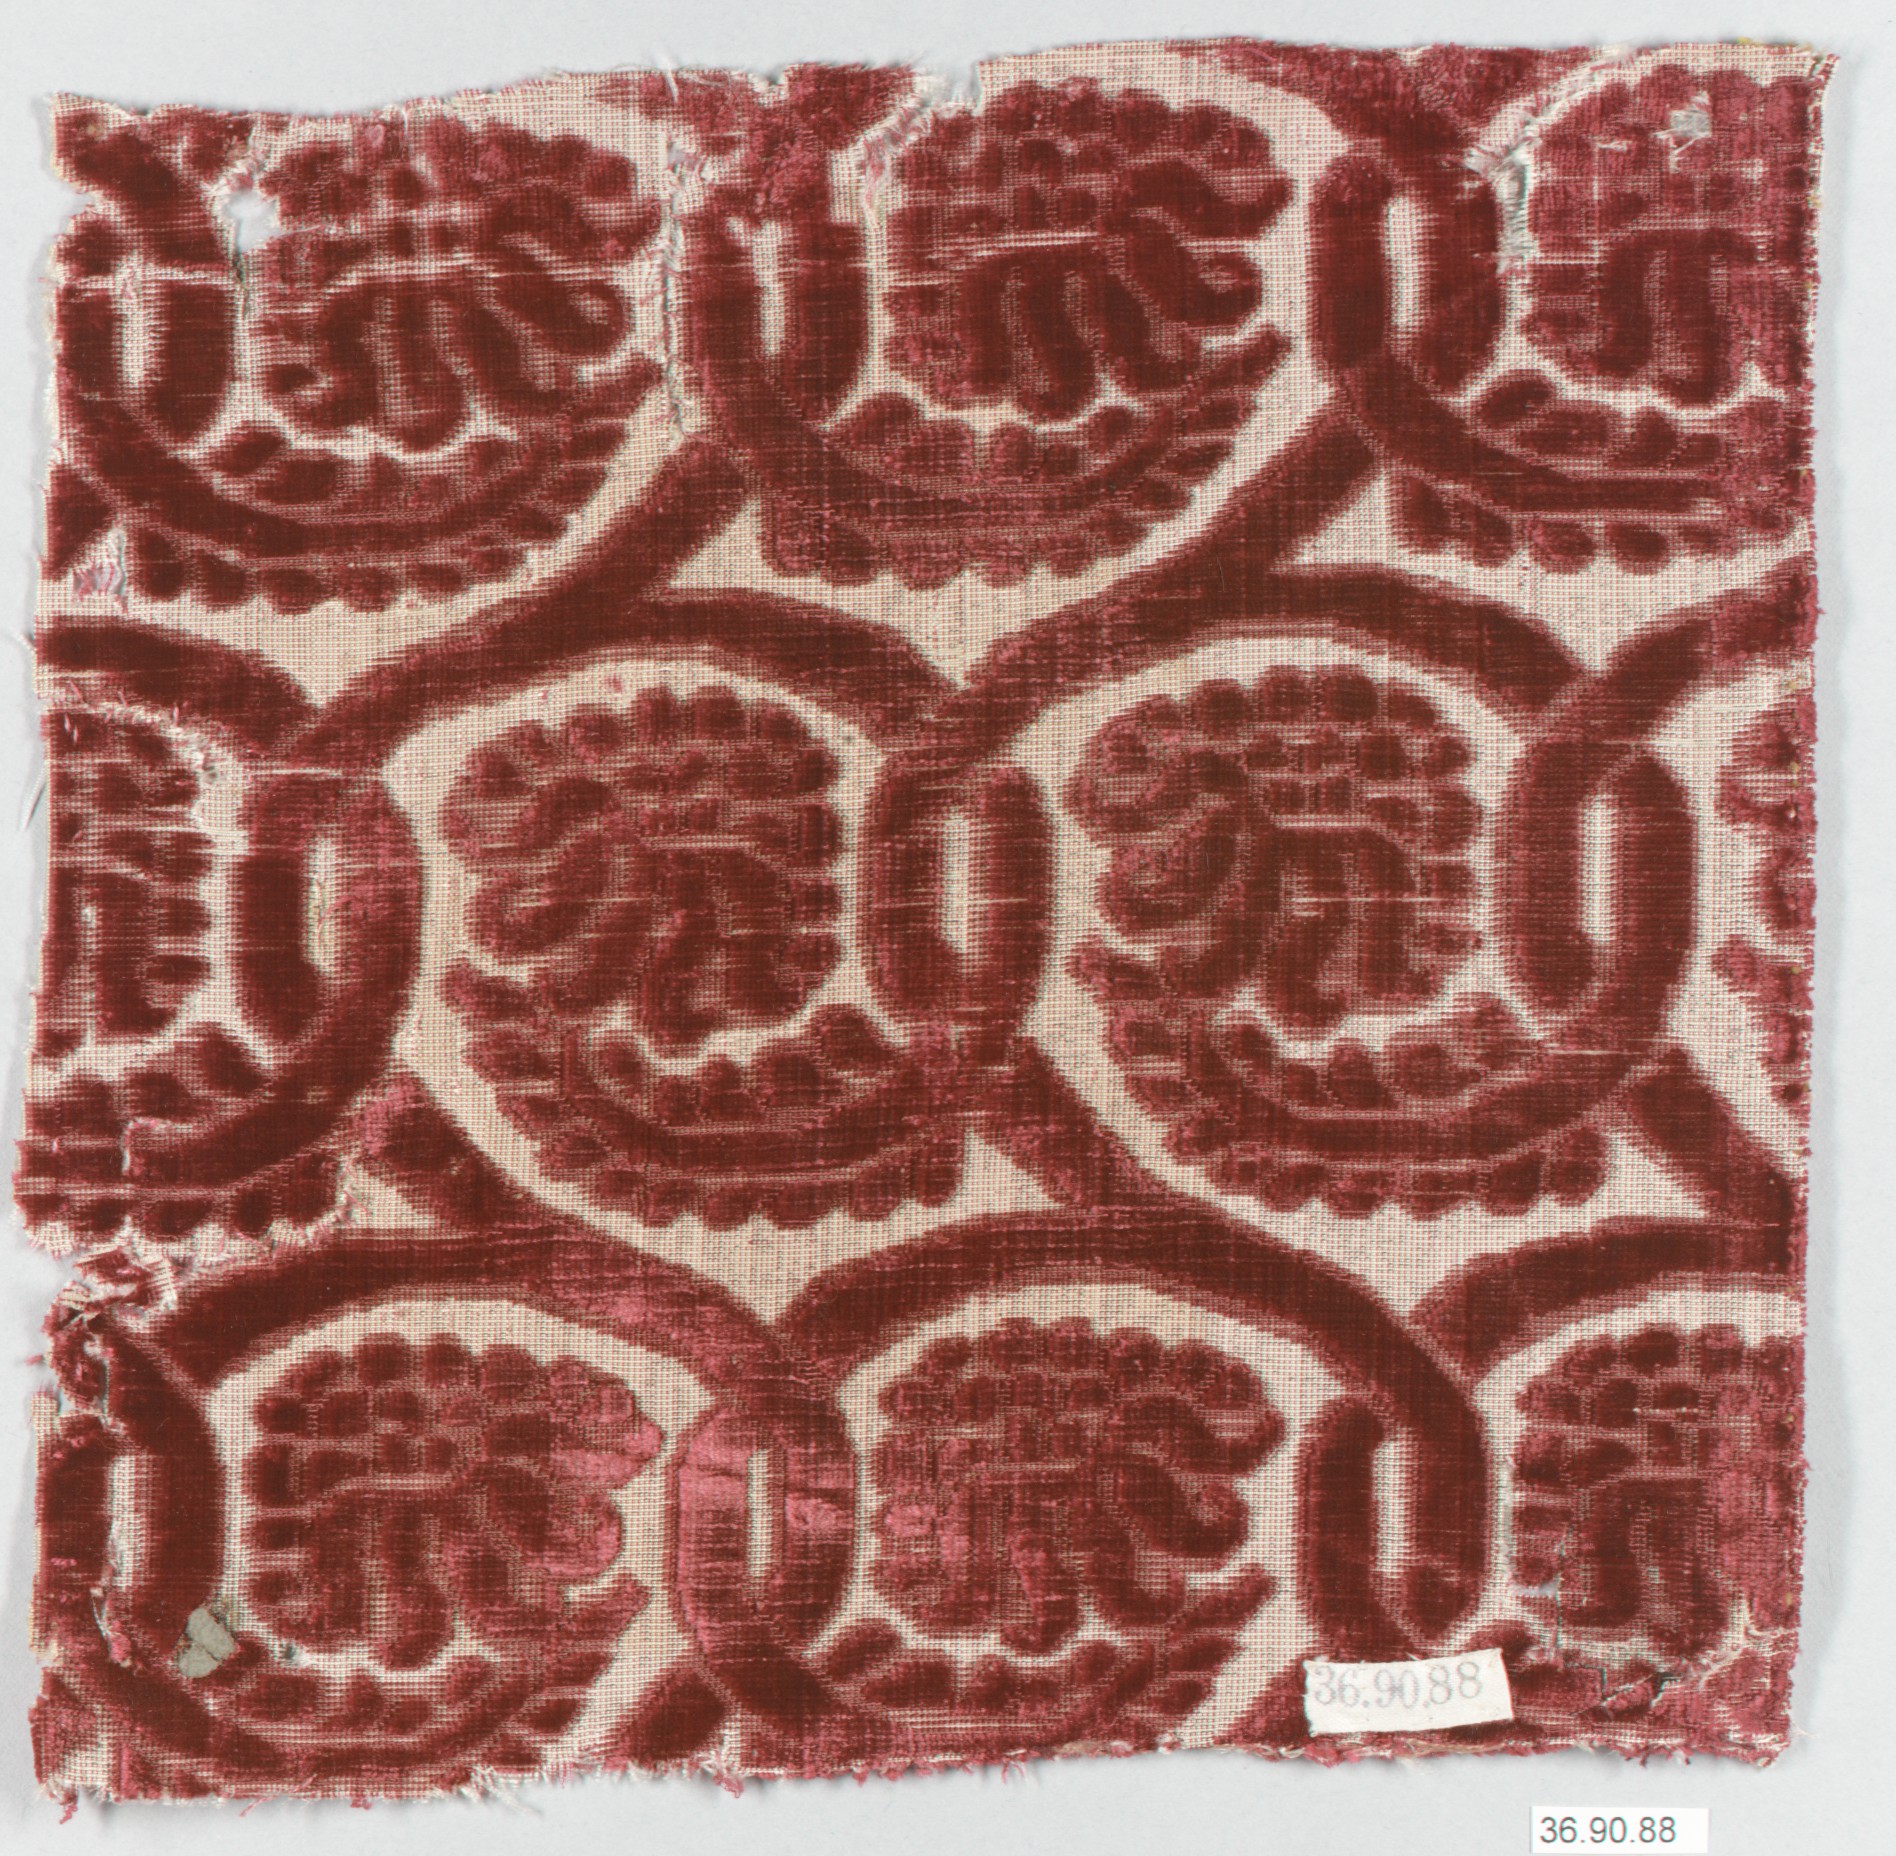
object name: piece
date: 1501-1700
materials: metal thread, silk